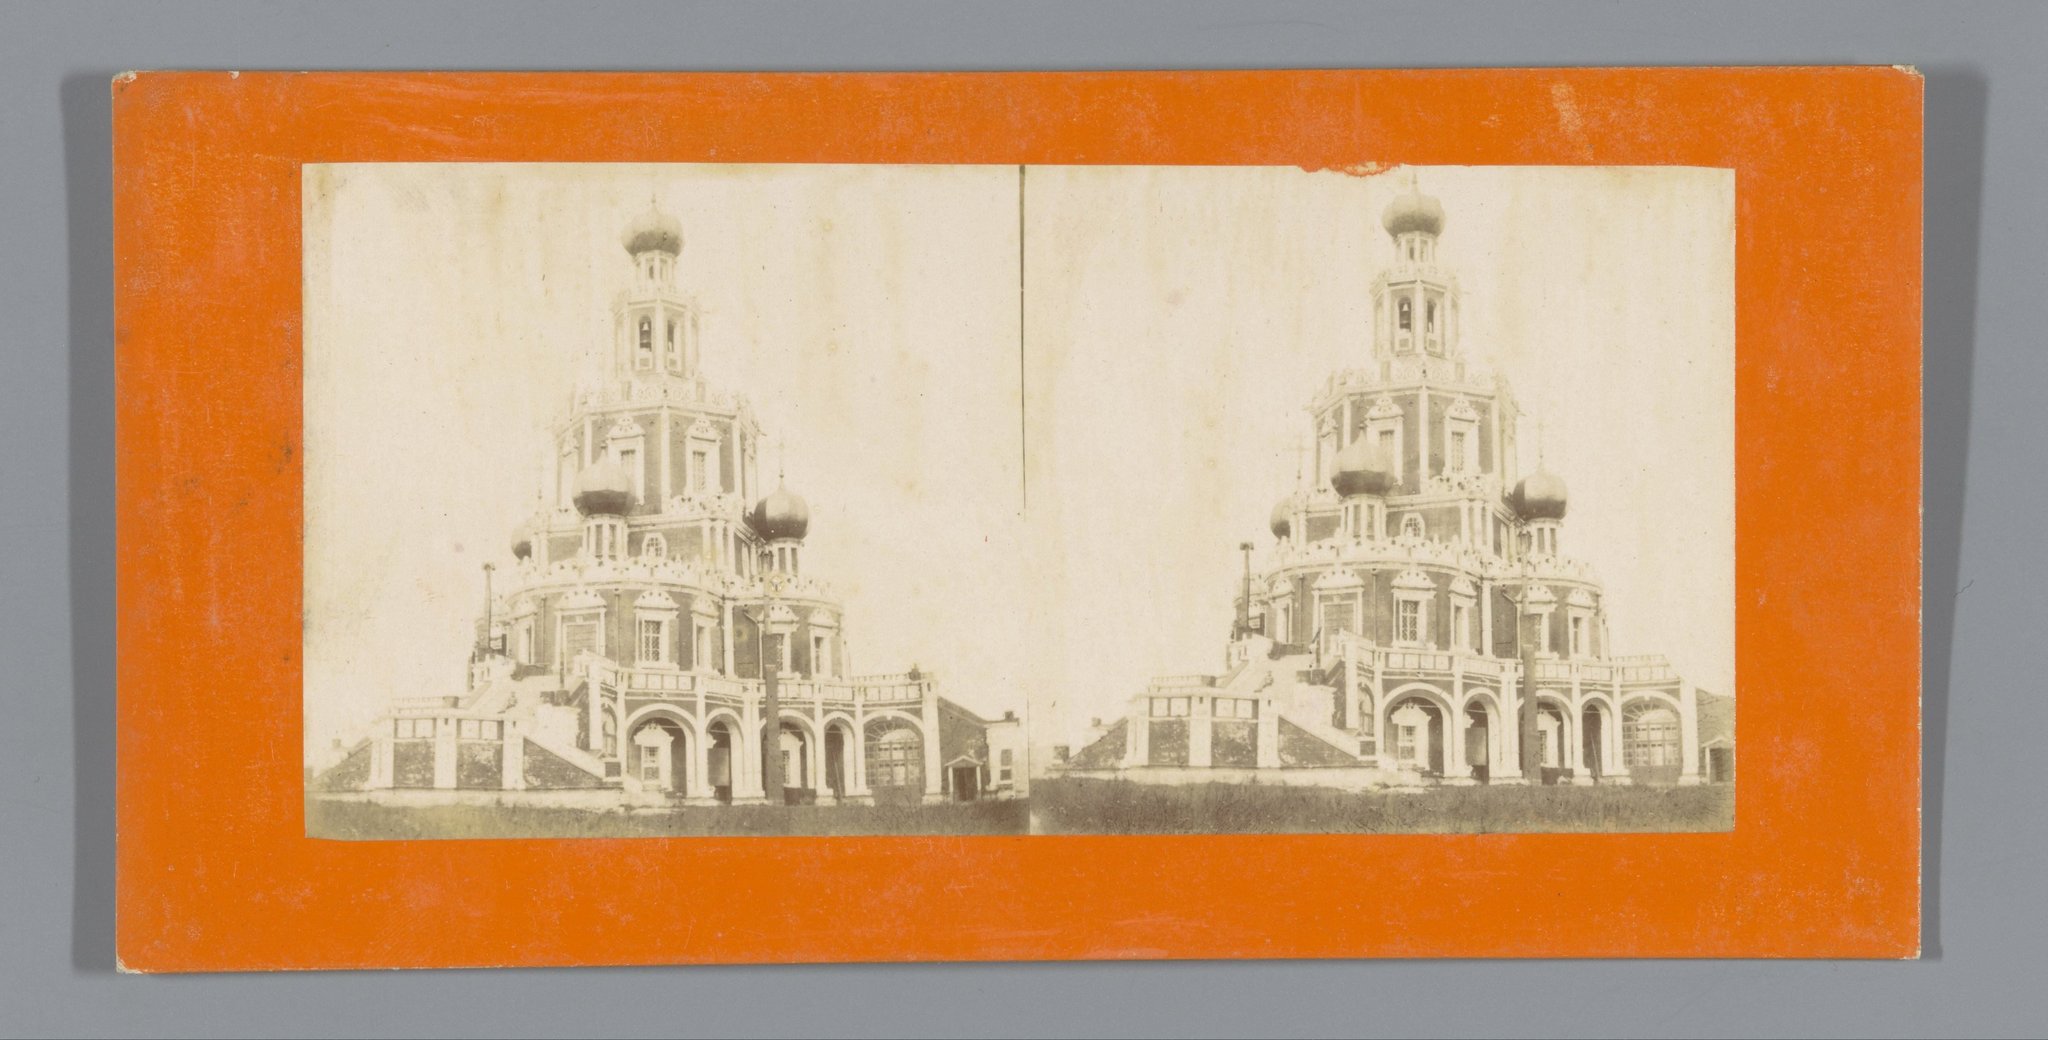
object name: stereograph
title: Gezicht op een paleis van Peter de Grote I in Moskou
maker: Anonymous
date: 1850-1880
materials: cardboard, photographic support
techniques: albumen print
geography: moscow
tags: palace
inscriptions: inscription: ‘67 Le palais de Pierre le grand Moscou’